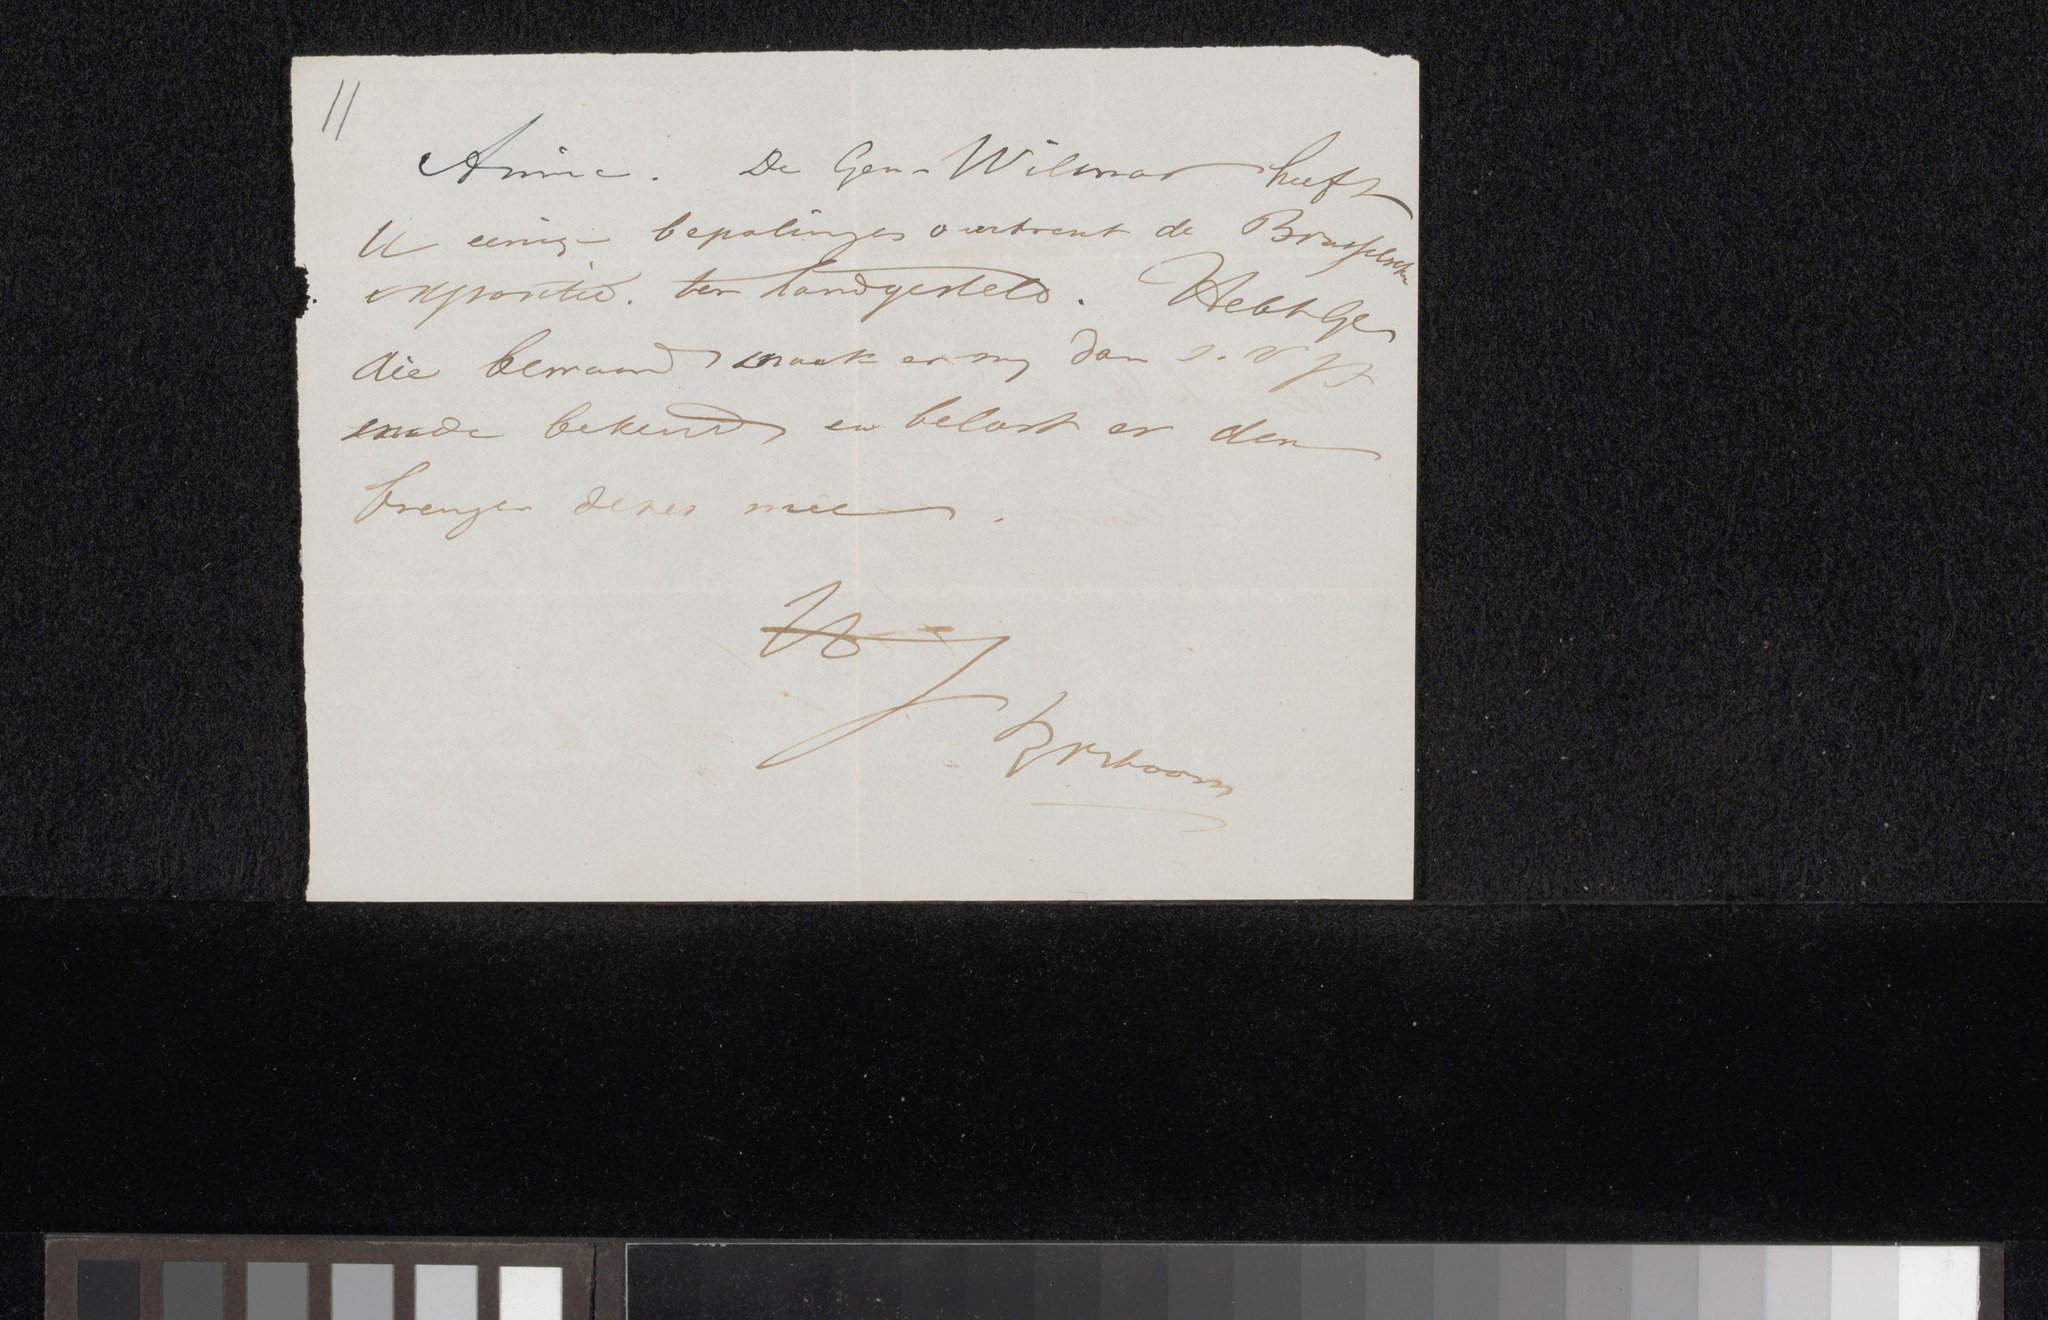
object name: letter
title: Brief aan Lambertus Hardenberg (1822-1900)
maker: johannes bosboom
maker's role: draughtsman, painter, print maker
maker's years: 1817-1891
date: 1827-1891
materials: ink, paper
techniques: pen, writing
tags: the hague, painter, print maker, draughtsman, lambertus hardenberg (1822-1900), exhibition ~ art, brussels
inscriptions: collector's mark: Lugt 2233